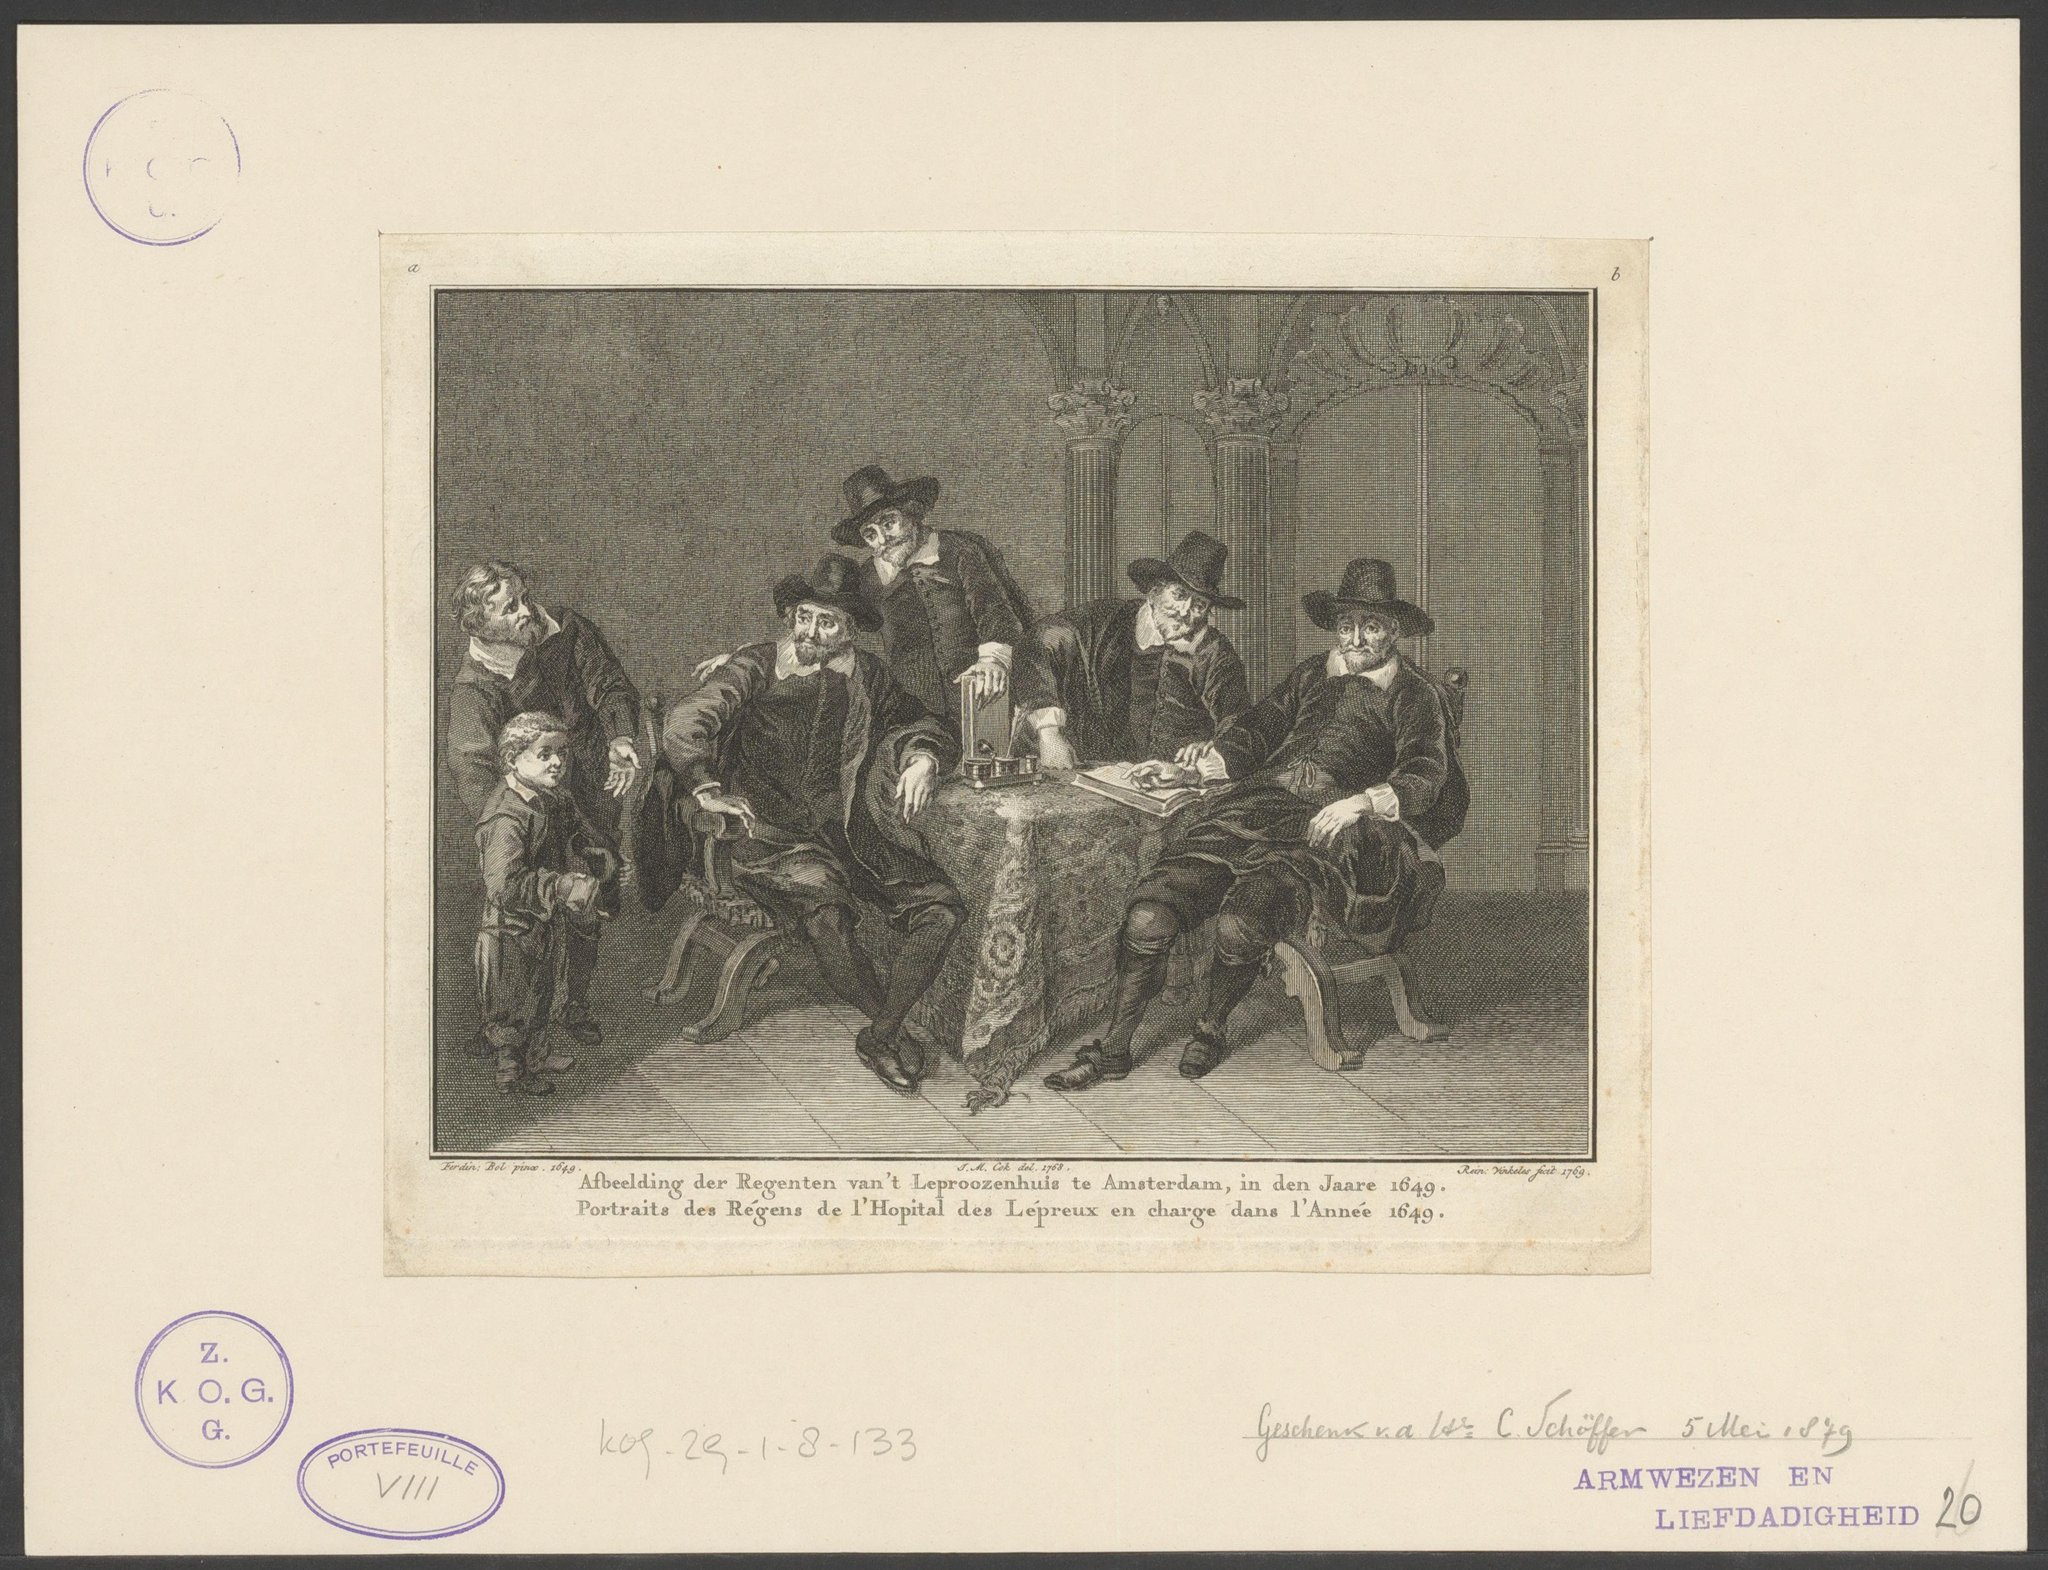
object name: print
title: Afbeelding der regenten van 't Leproozenhuis te Amsterdam, in den Jaare 1649 / Portraits des Régens de l'Hopital des Lépreux en charge dans l'Année 1649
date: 1769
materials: paper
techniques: engraving, etching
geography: amsterdam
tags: leprosarium, charitable works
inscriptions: collector's mark, collector's mark: Lugt 1641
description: Groepsportret van de regenten van het Leprozenhuis, geschilderd door Ferdinand Bol in 1649. Een vergadering van de regenten wordt onderbroken door de binnenvader die een ziek kind binnen leidt. Onderwerpsrubrieken binnen de Atlas Zeden en Gewoonten: Armwezen en Liefdadigheid.